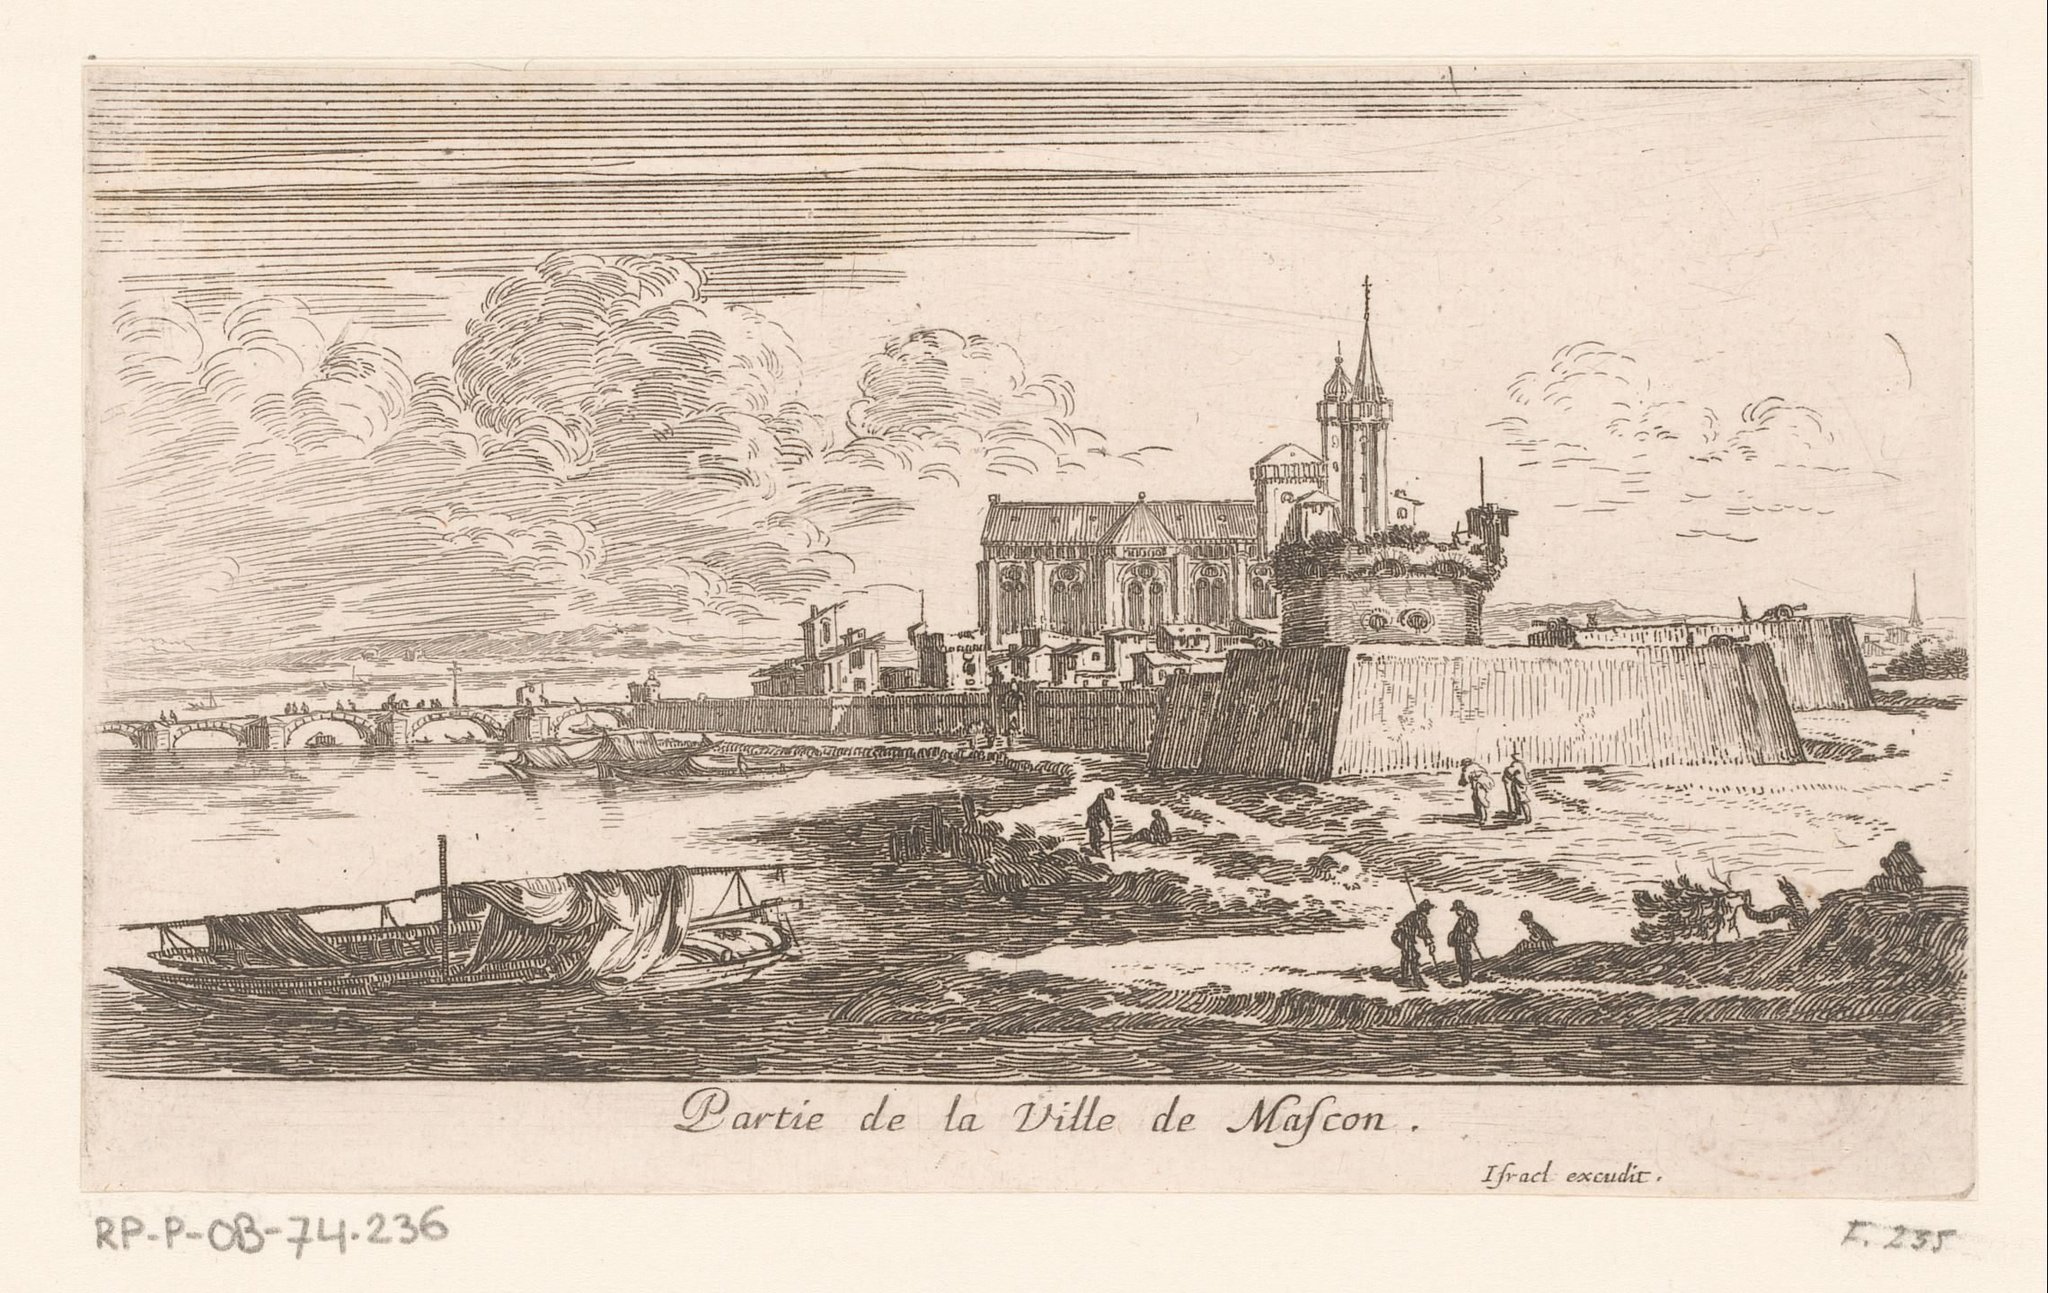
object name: print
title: Partie de la Ville de Mascon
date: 1631-1691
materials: paper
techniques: engraving, etching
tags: city-view, and landscape with man-made constructions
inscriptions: collector's mark: Lugt 240